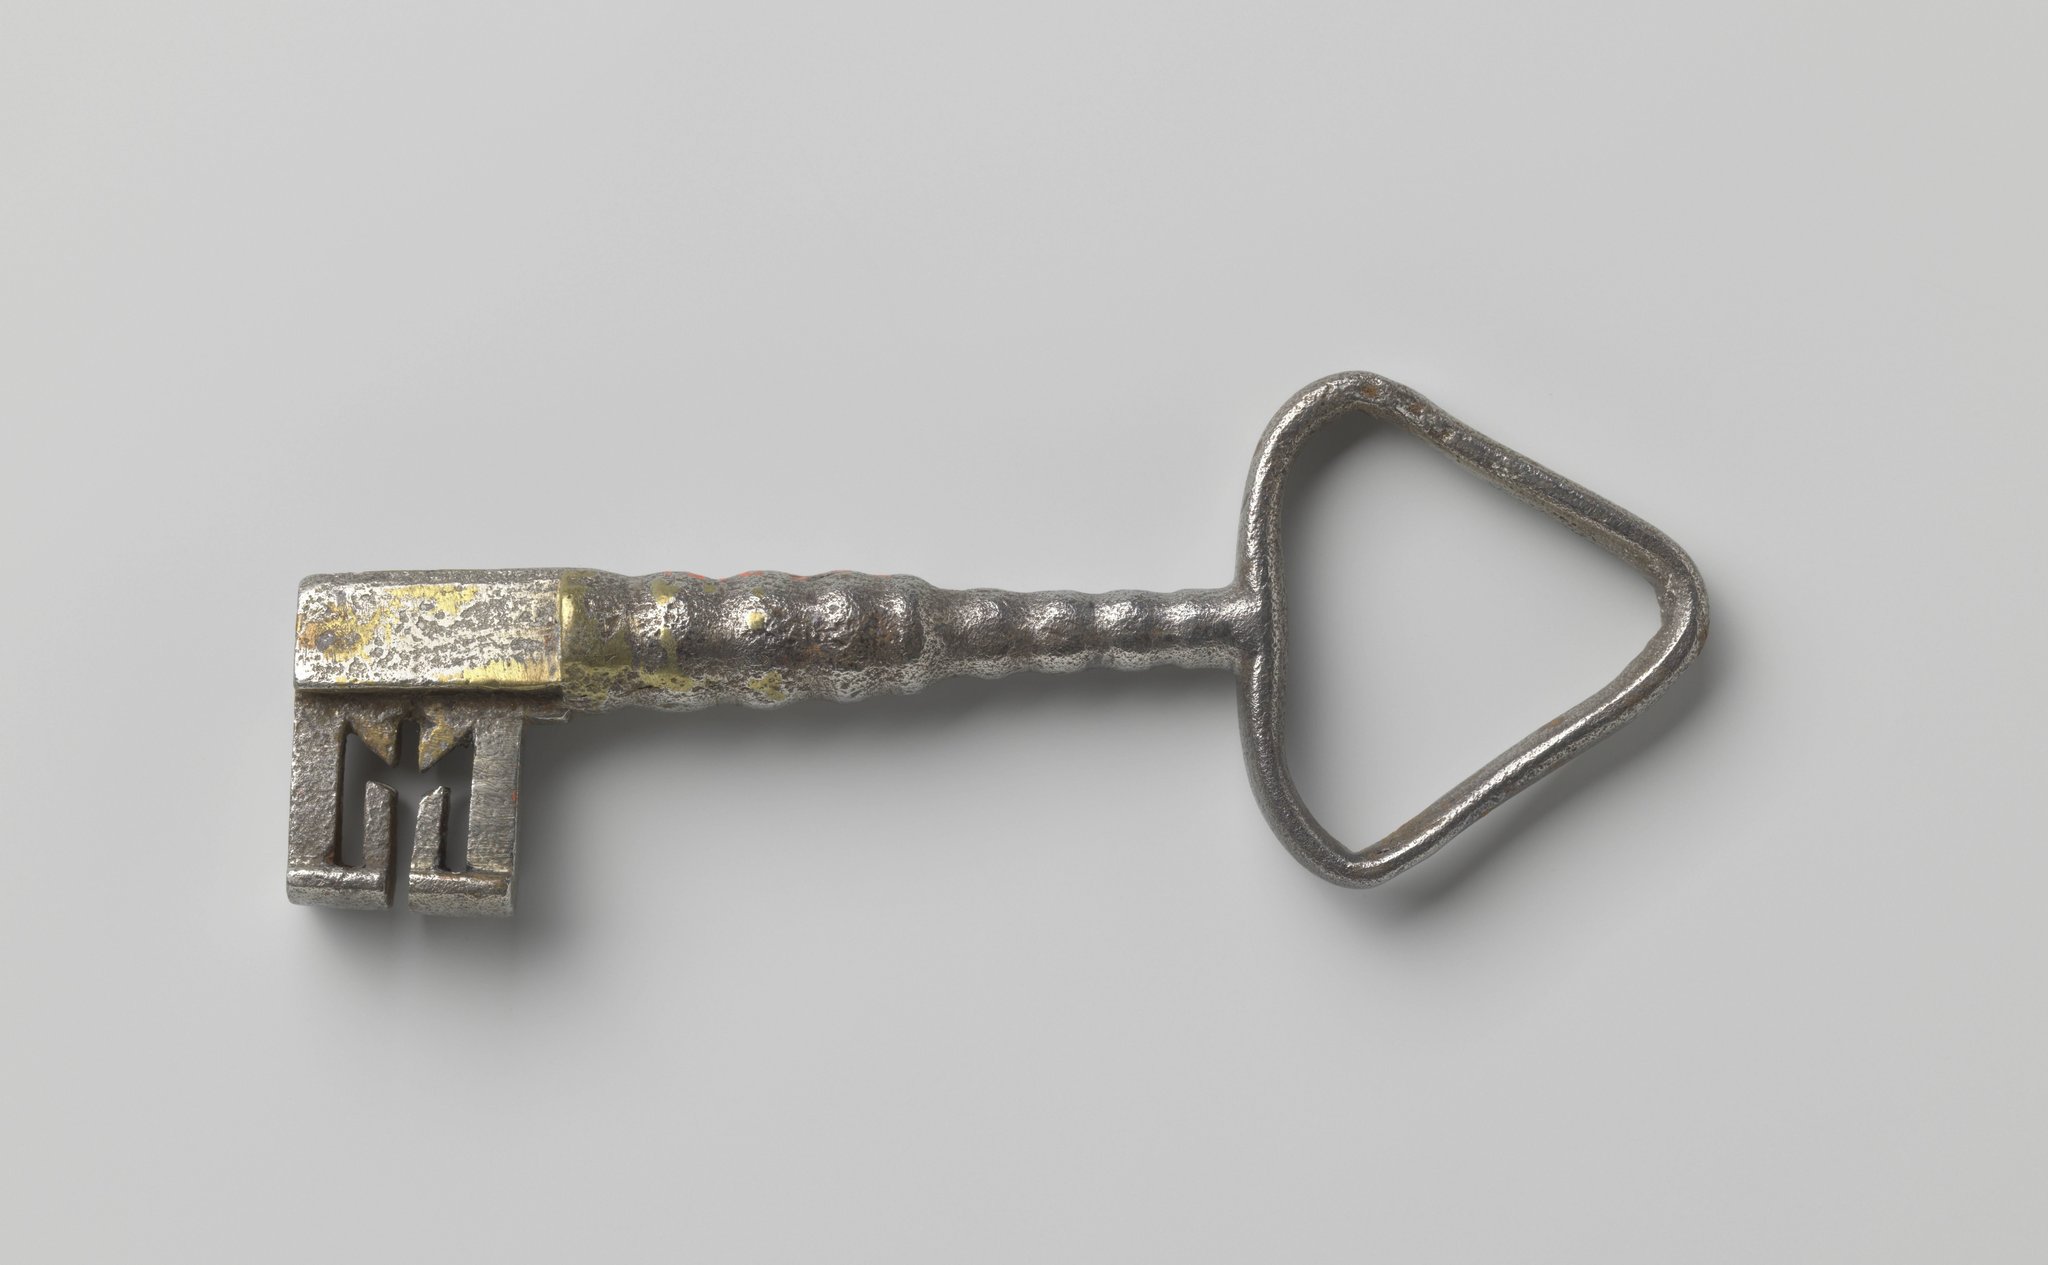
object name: key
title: Sleutel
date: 1700-1800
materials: iron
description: Sleutel met driehoekig oog, gegolfde schacht, die zich naar onderen verbreedt en daarna driezijdig verloopt. De baard heeft een bezetting gelijkende op een gestileerde Duitse adelaar.